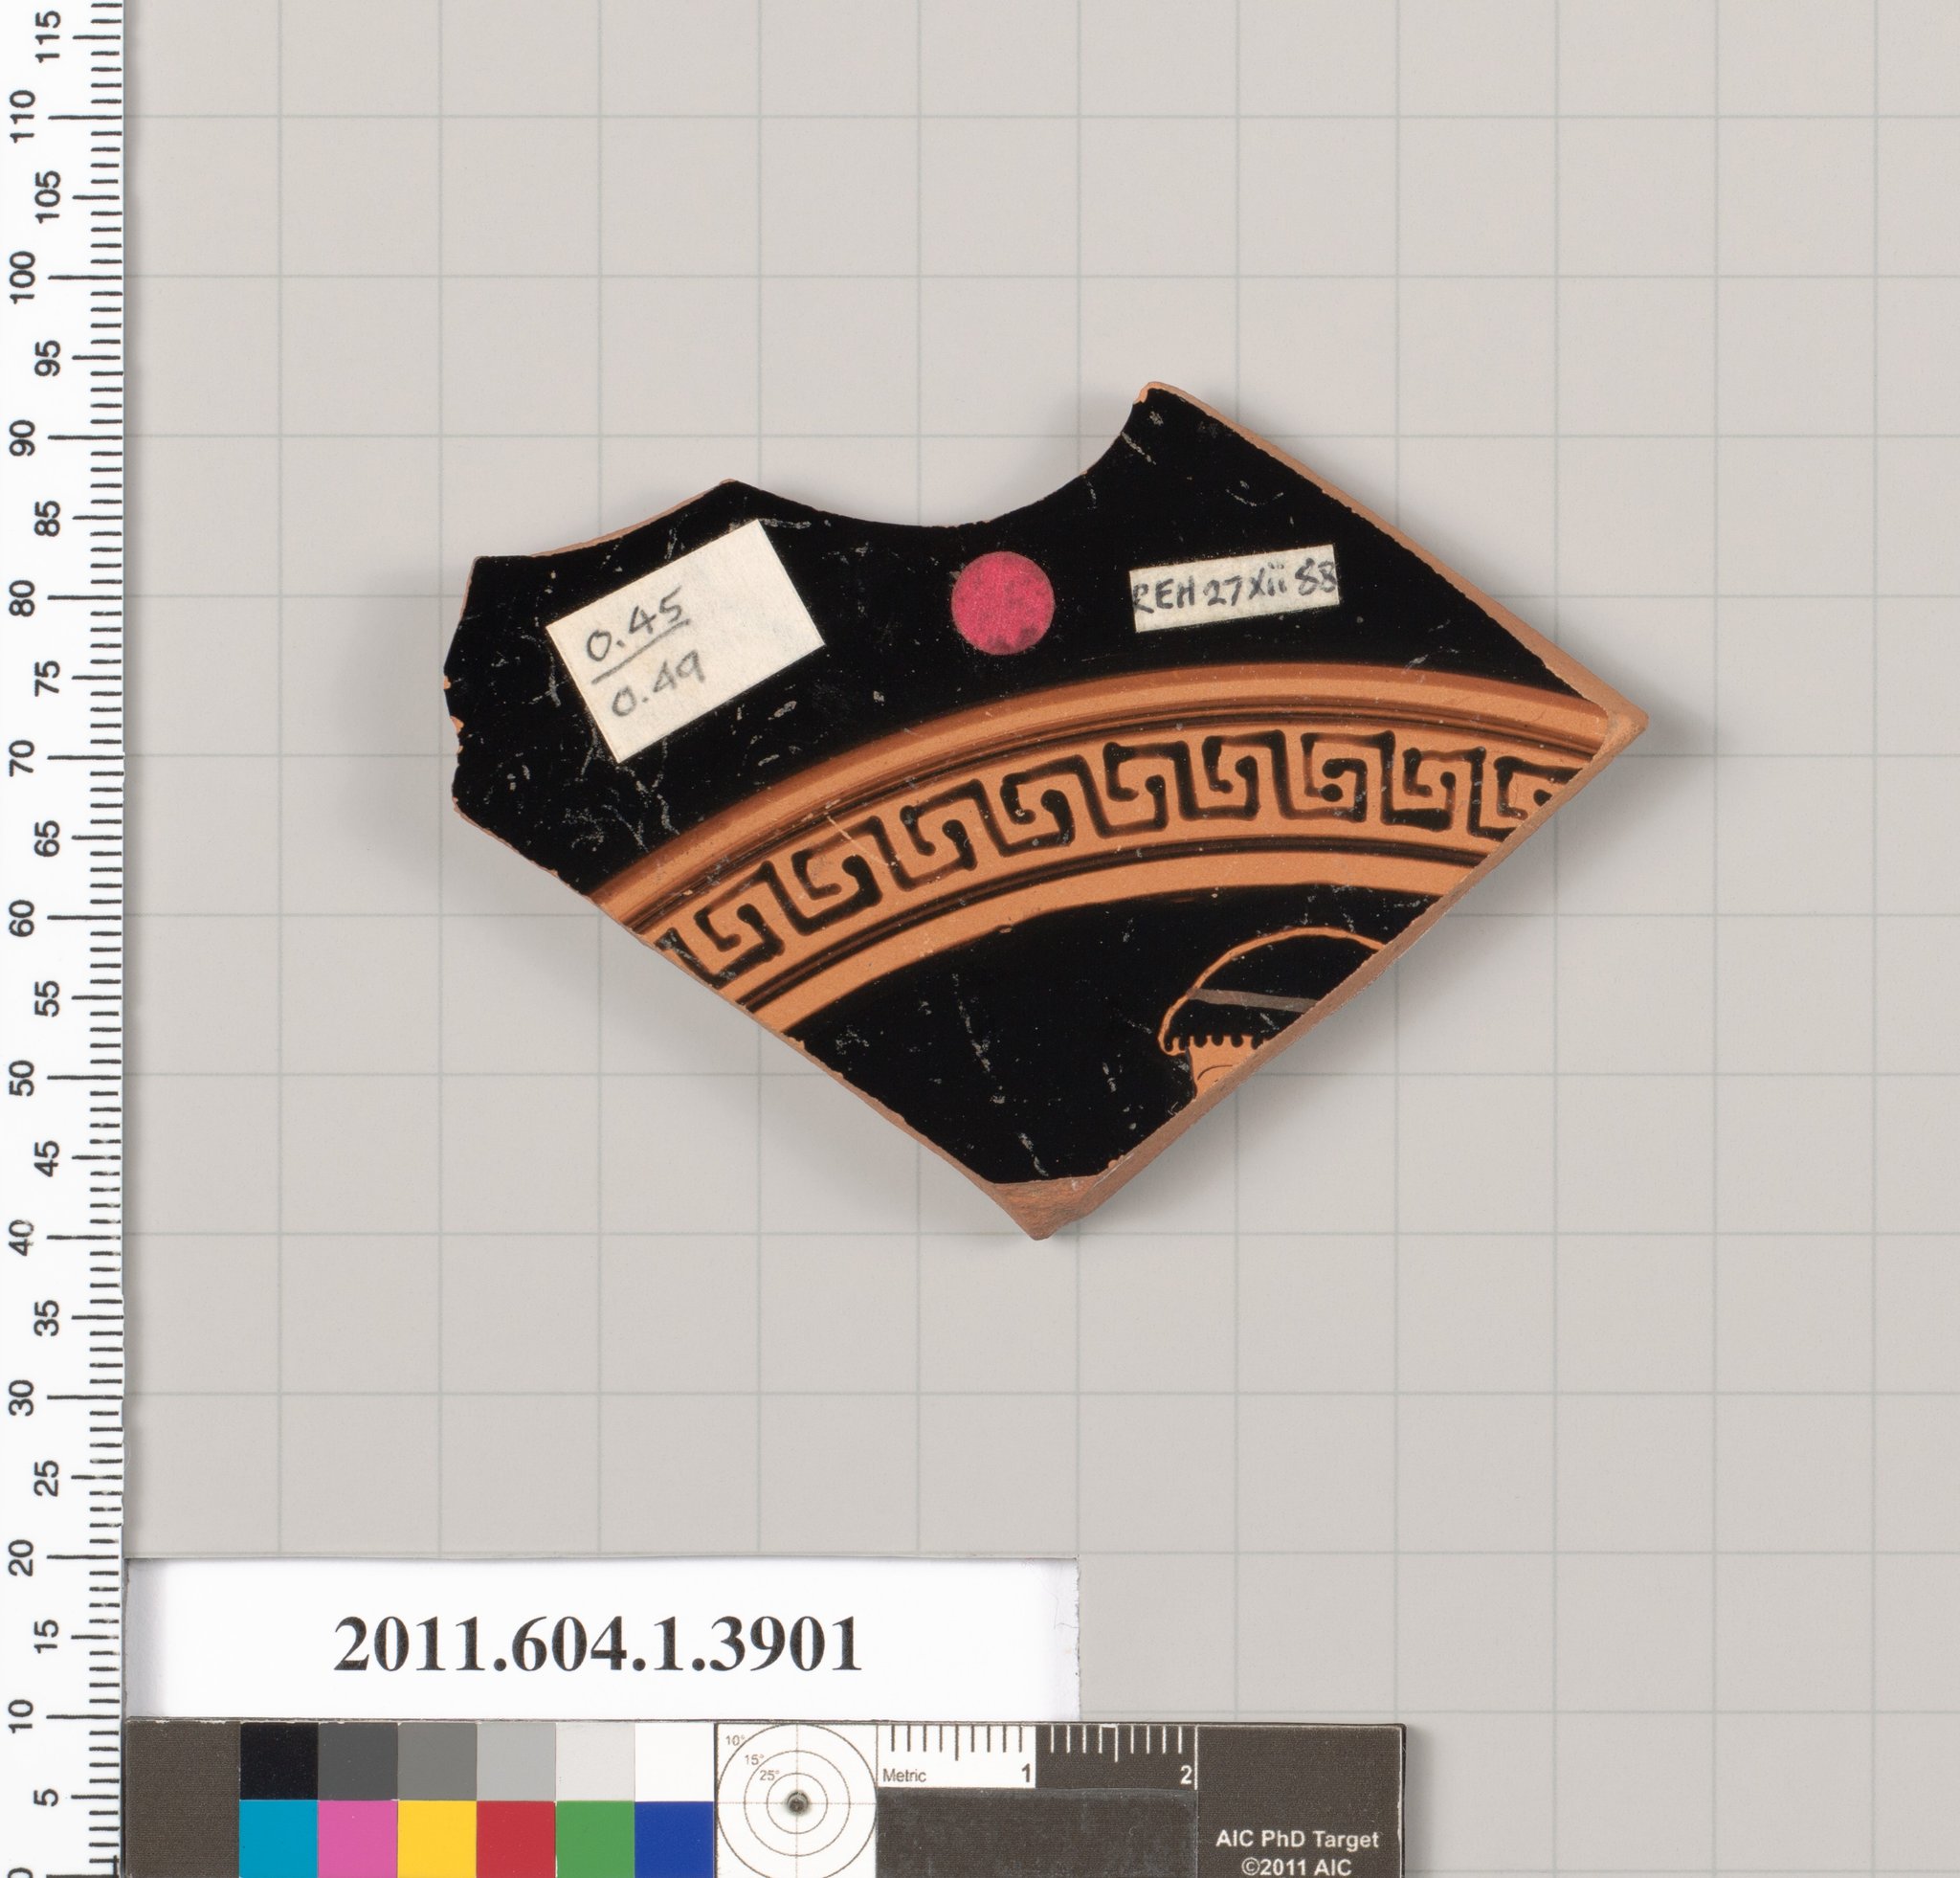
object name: kylix fragment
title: Terracotta fragment of a kylix (drinking cup)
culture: greek, attic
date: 500-476 BCE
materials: terracotta